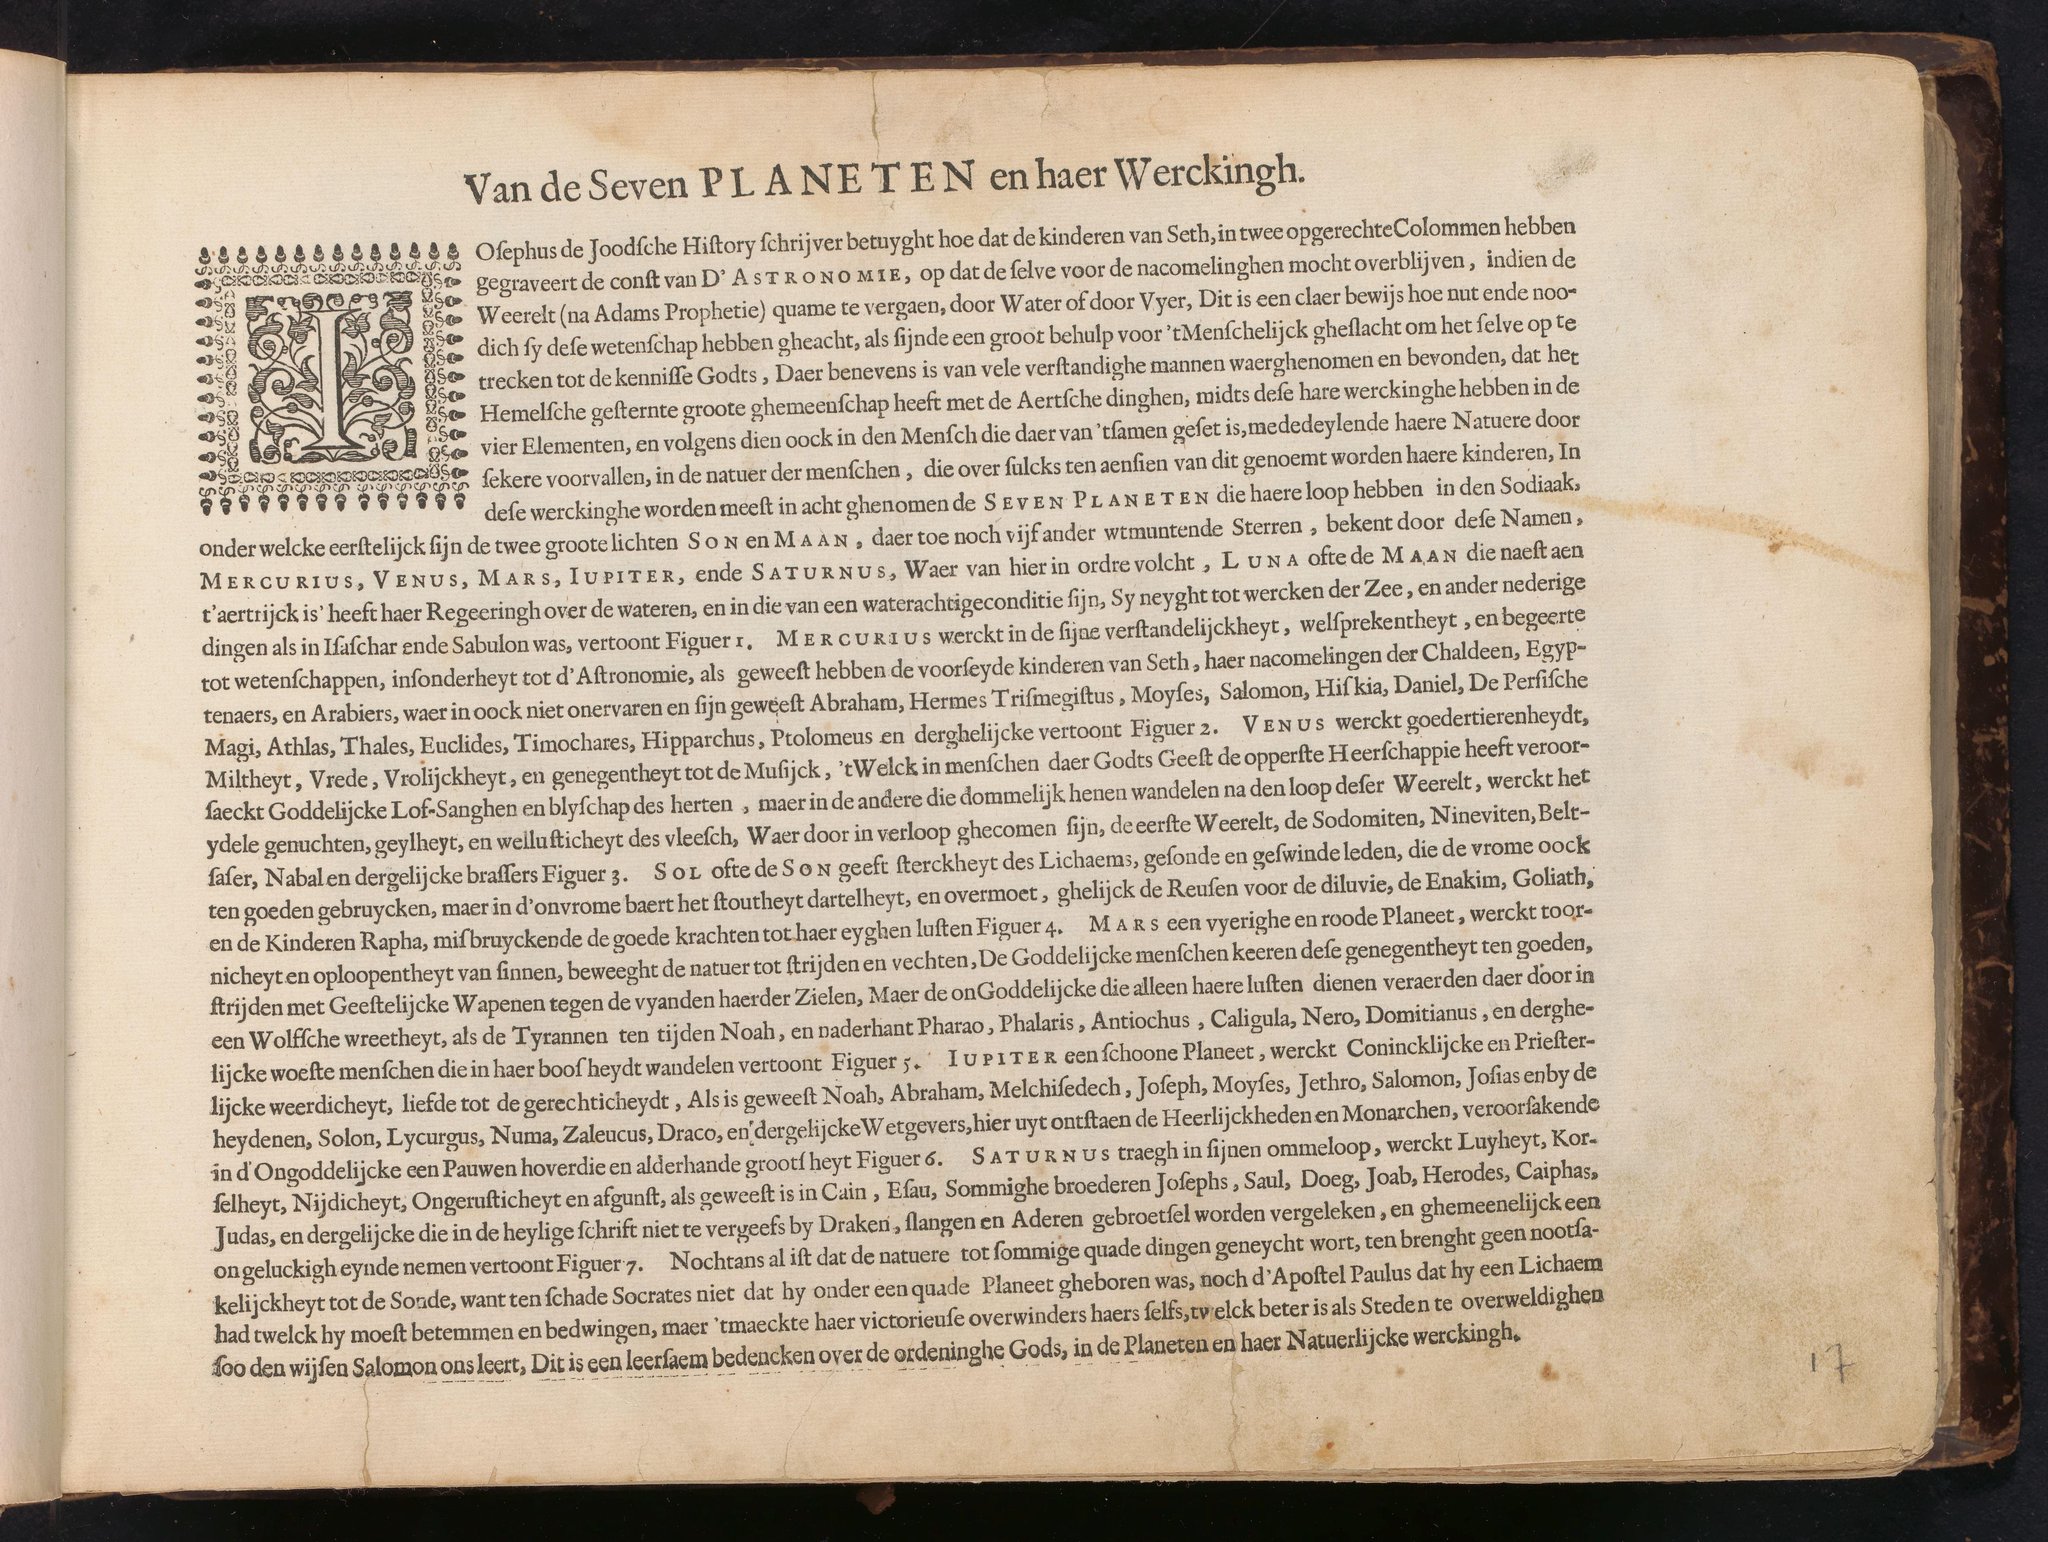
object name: album leaf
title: Van de Seven Planeten en haer Werkingh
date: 1646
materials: paper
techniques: letterpress printing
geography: alkmaar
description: Tekstblad bij een serie prenten over de zeven planeten. Dit blad maakt deel uit van een album.